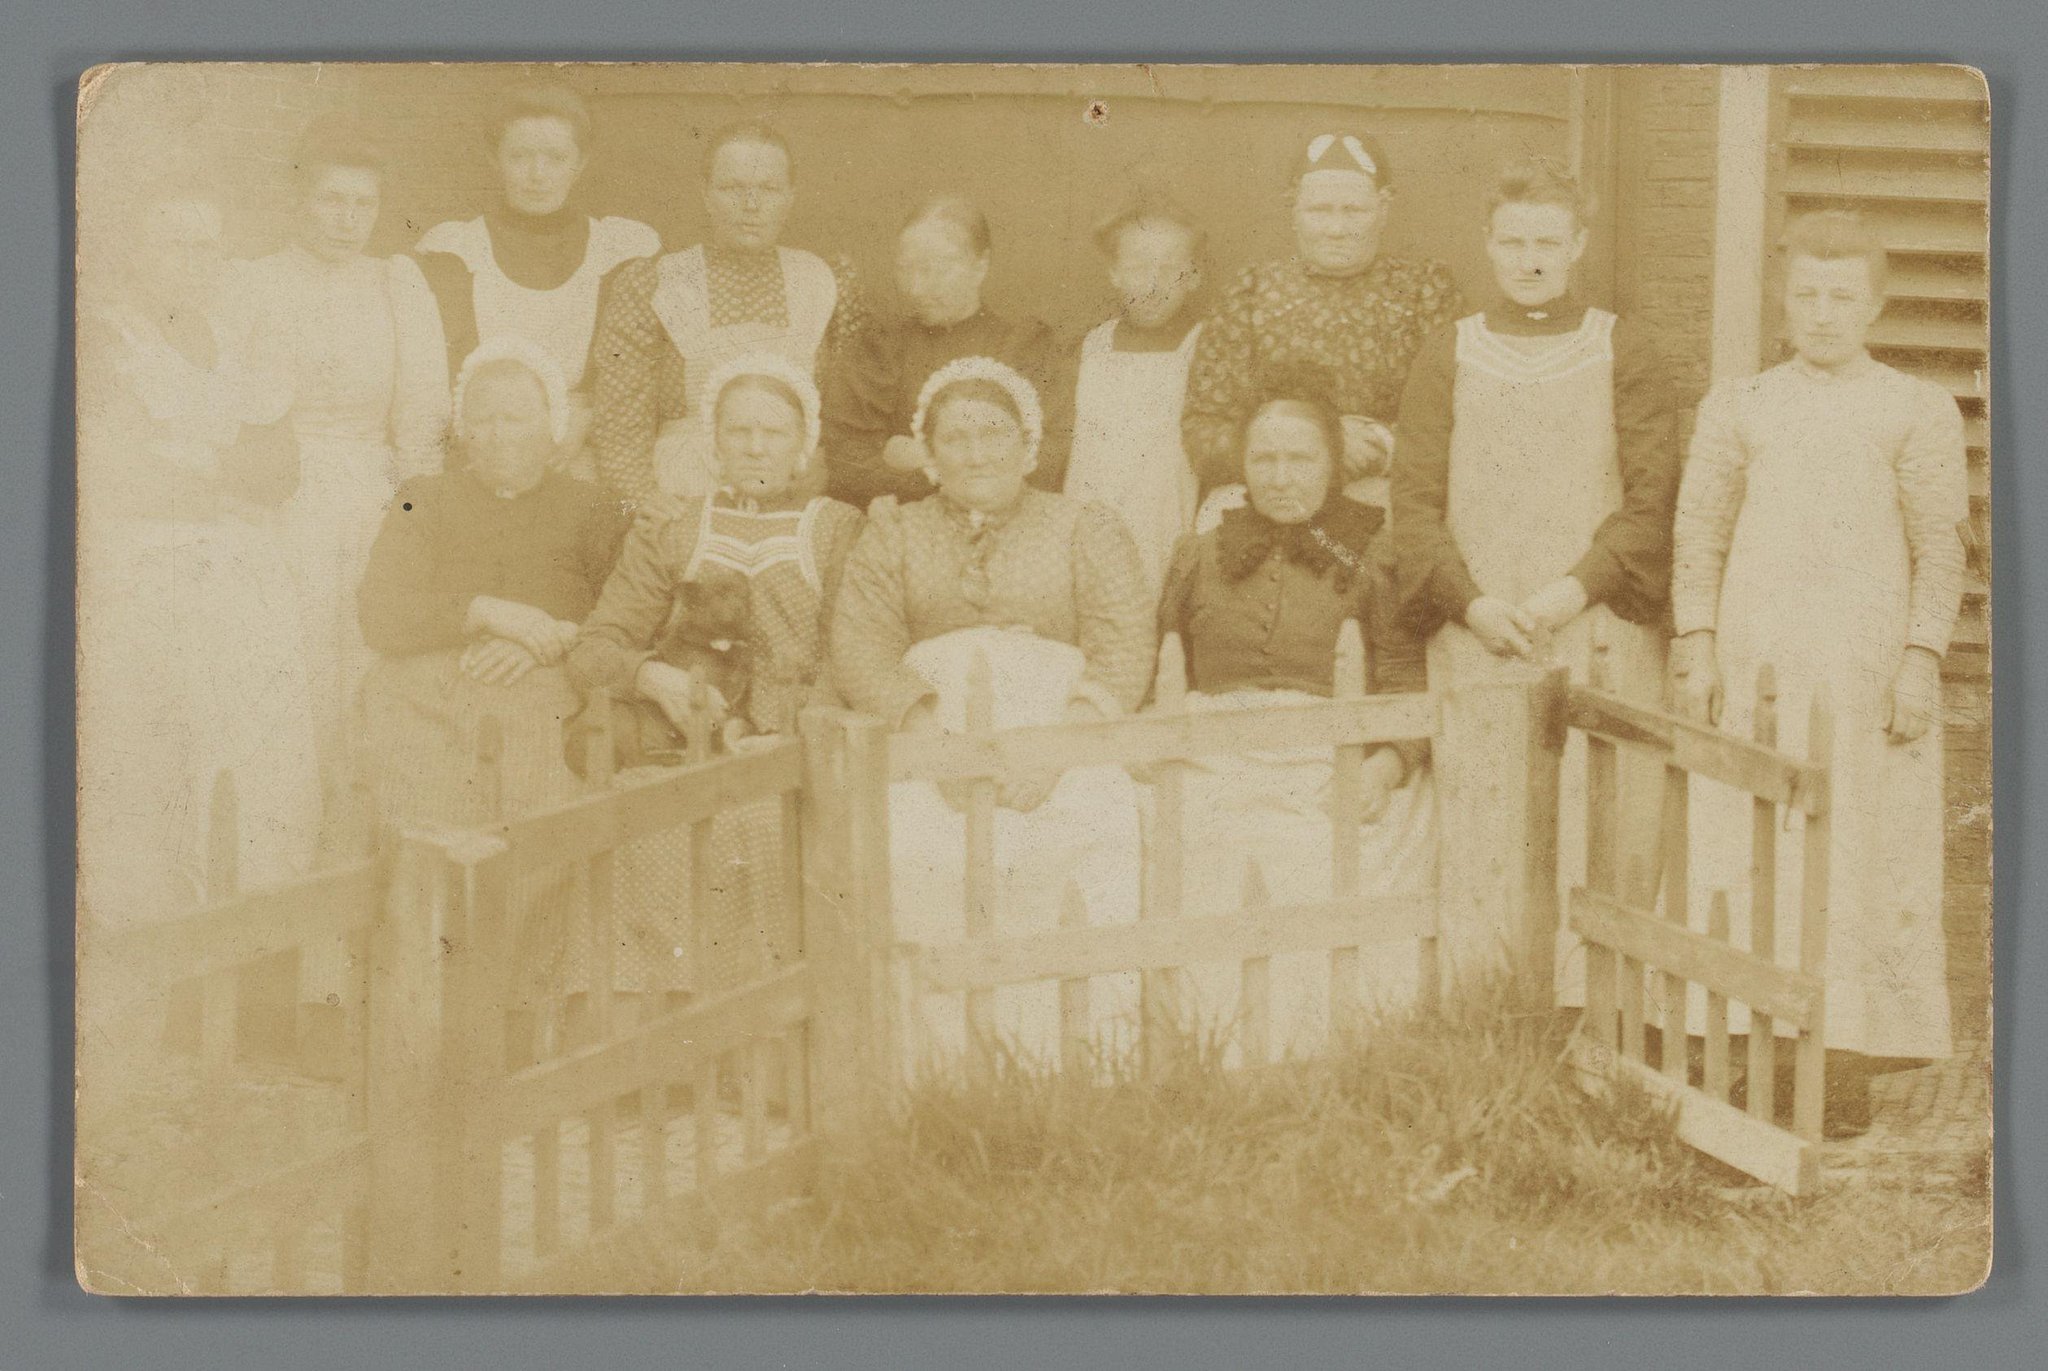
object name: photograph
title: Groepsportret van onbekende vrouwen zittend bij een hek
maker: Anonymous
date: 1905-1920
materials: paper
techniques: collodion silver print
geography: leeuwarden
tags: historical persons not known by name - bb - woman, anonymous historical persons portrayed in a group, in a group-portrait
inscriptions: inscription: ‘Moe Mendel’